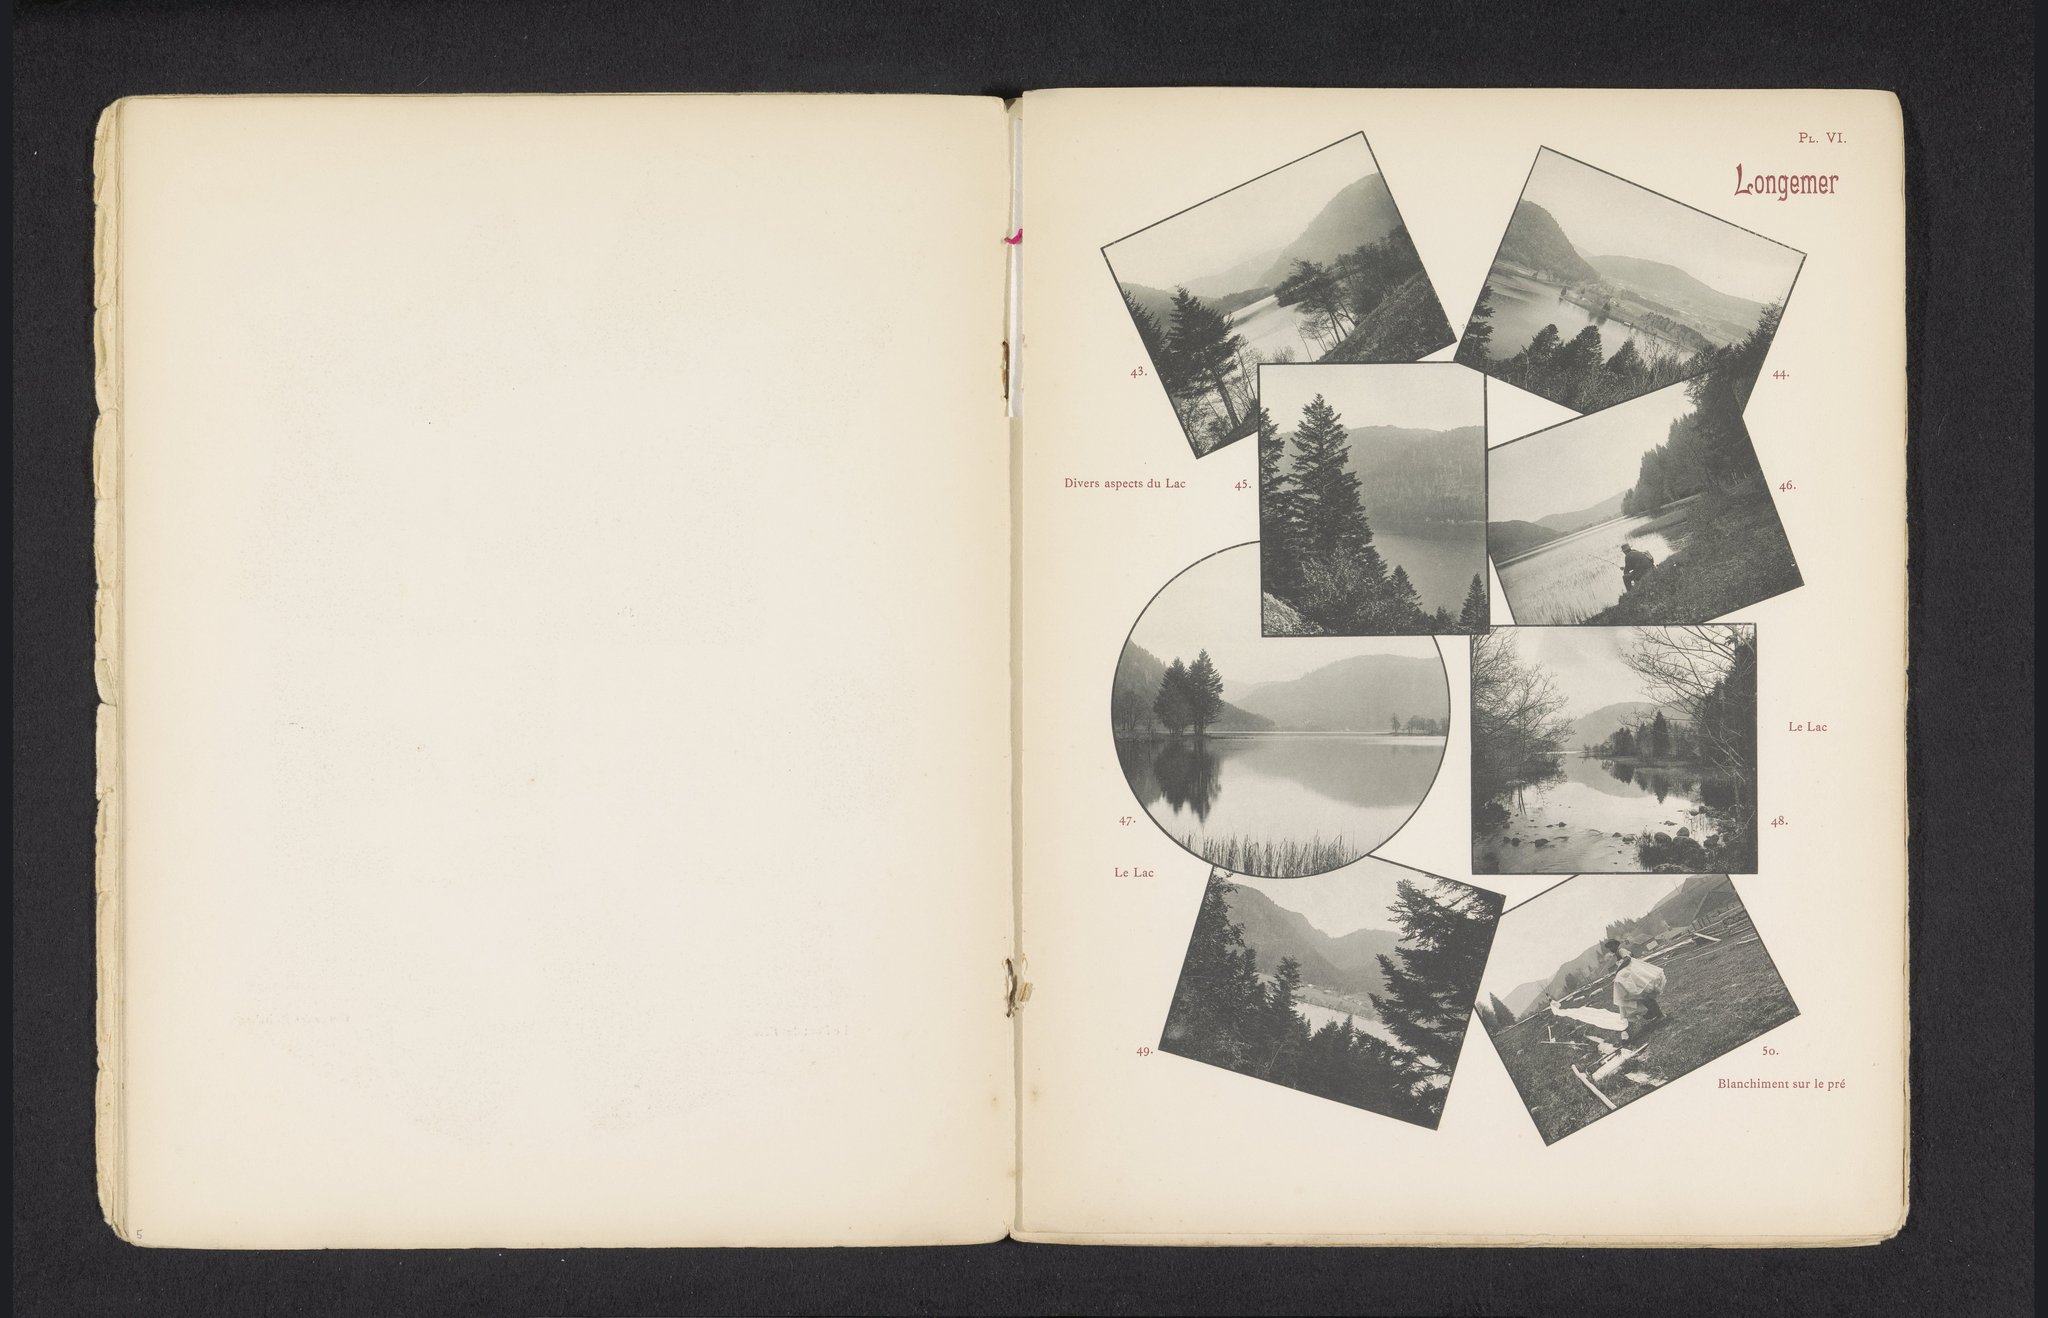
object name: photomechanical print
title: Longemer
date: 1888-1898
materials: paper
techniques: photograph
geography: vosges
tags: lake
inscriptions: number: ‘Pl. VI.’